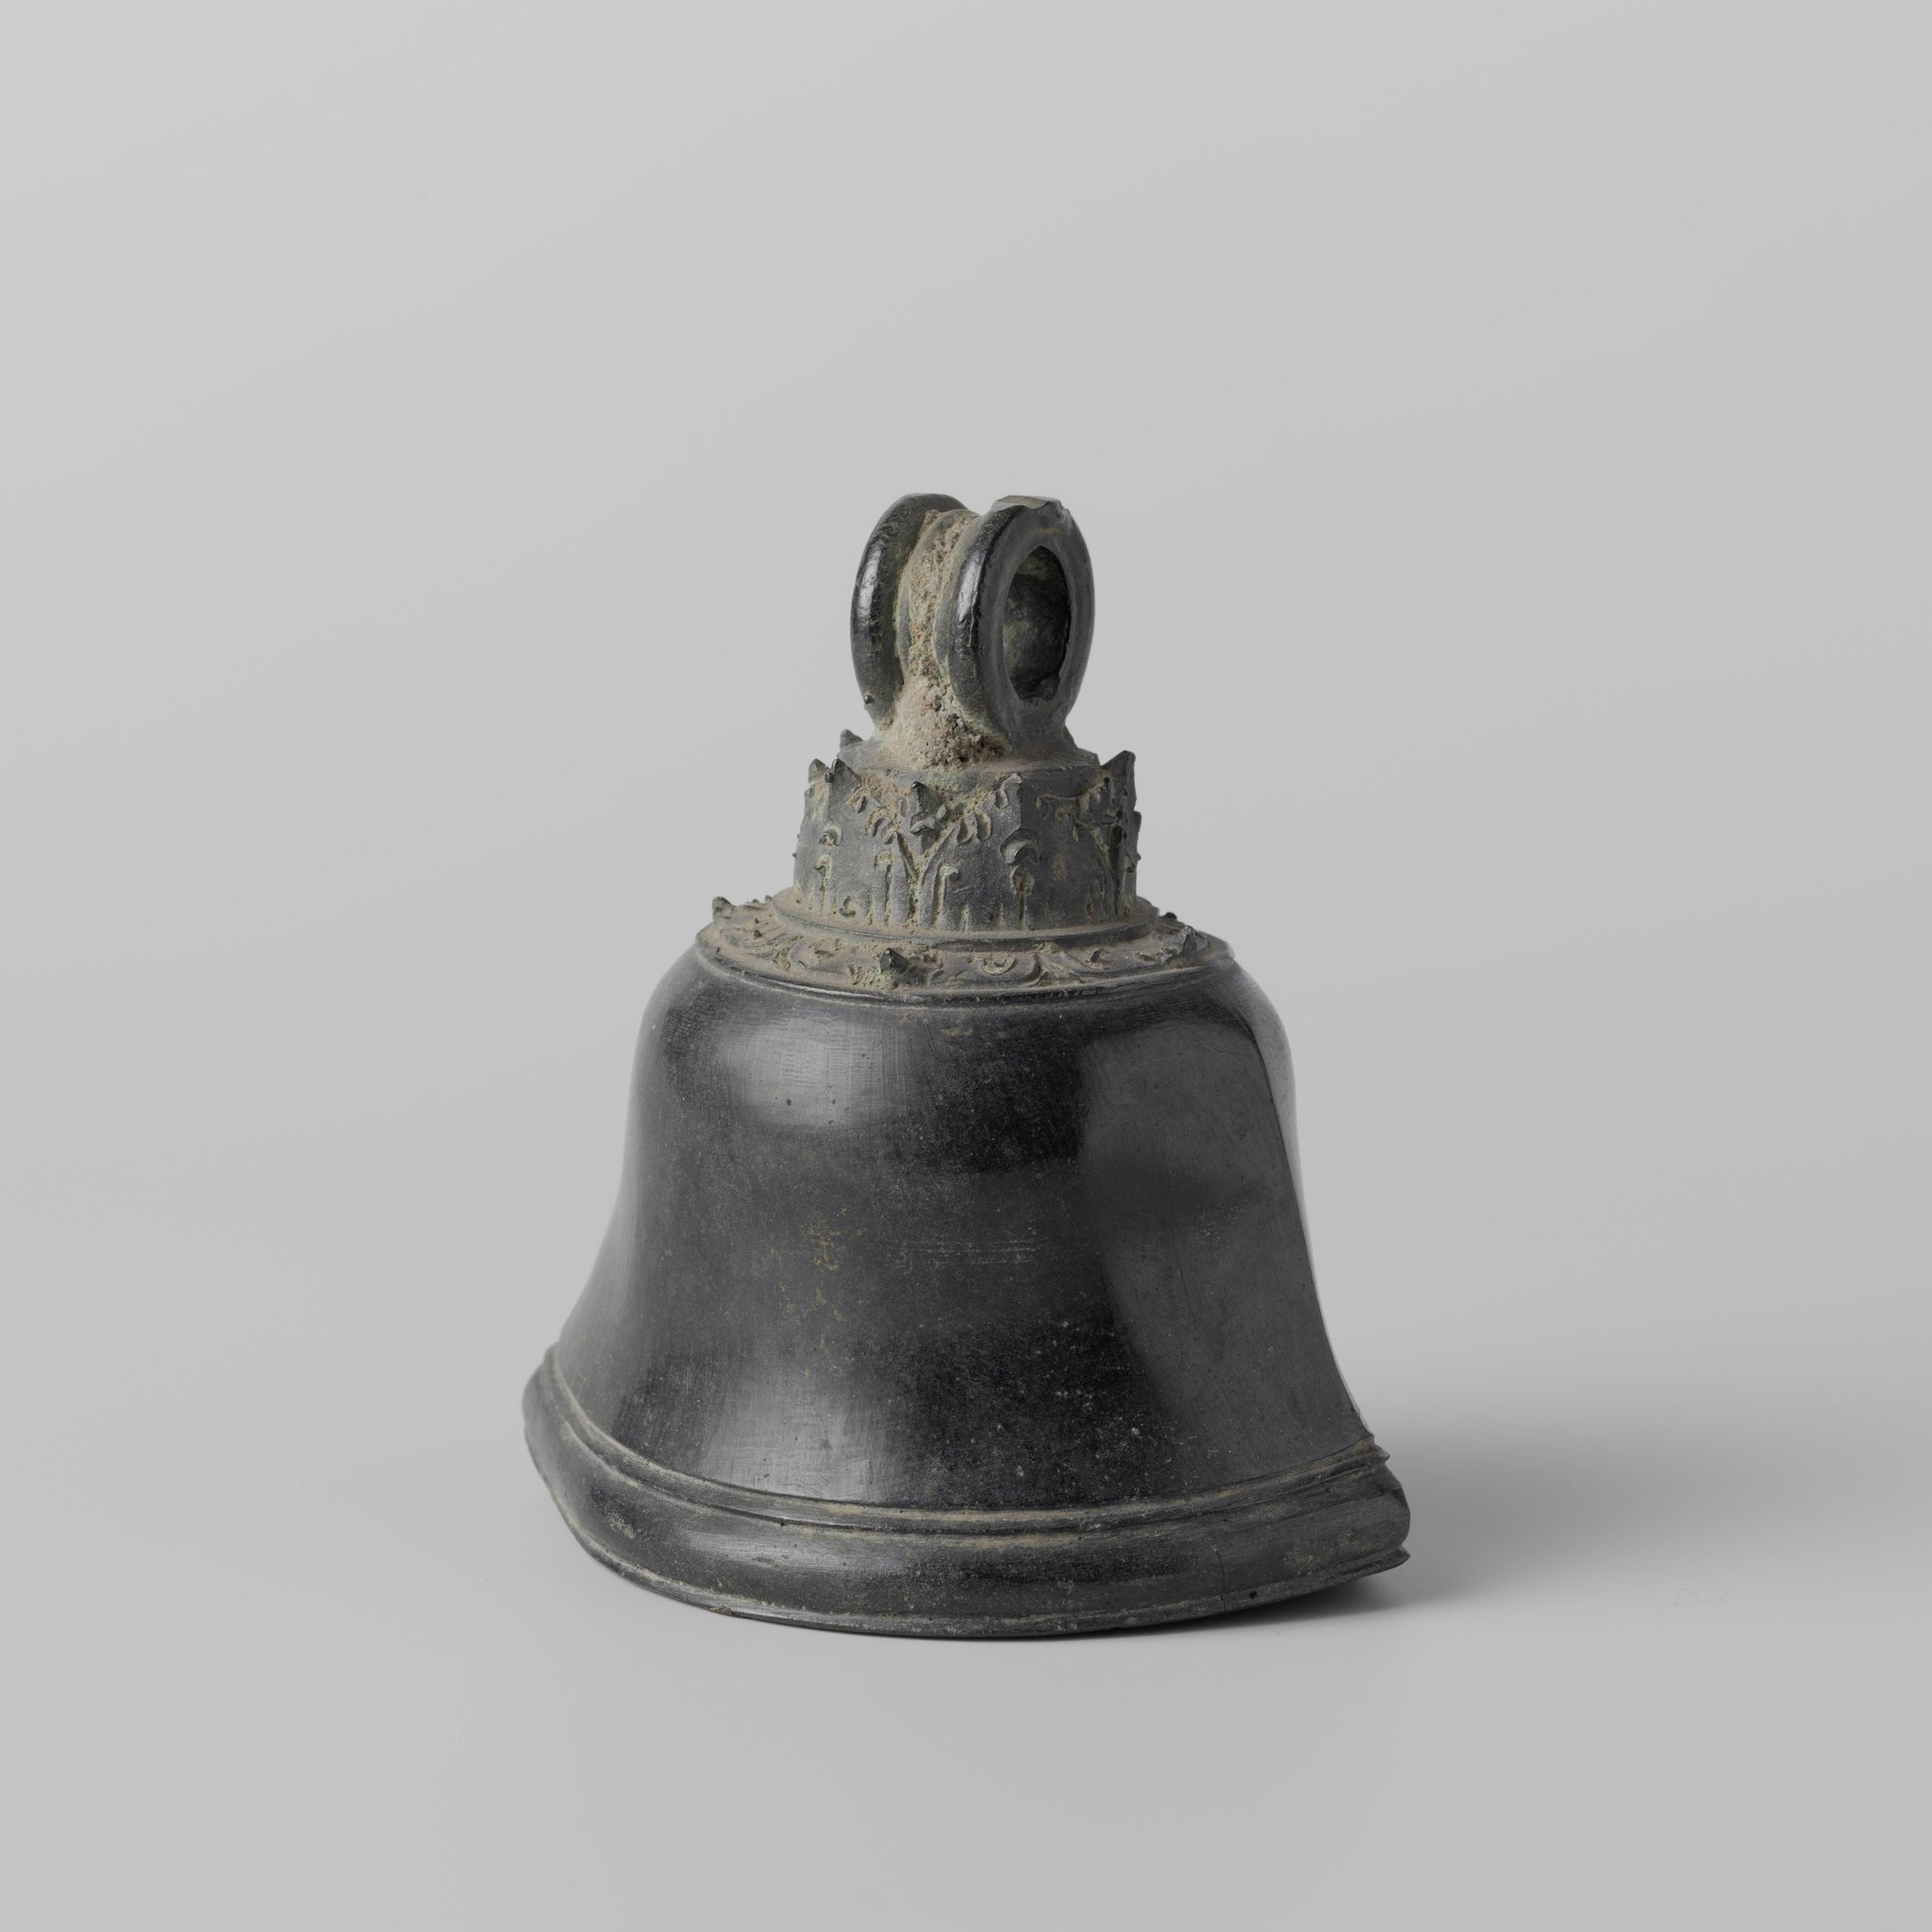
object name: percussion instrument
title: Bel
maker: Anonymous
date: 930-1600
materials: bronze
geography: indonesia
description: Olifanten- of koeienbel, brons, bekroond door lotuskussen met daarop rechtopstaande lotusbladen, om een cilinder gegroepeerd.